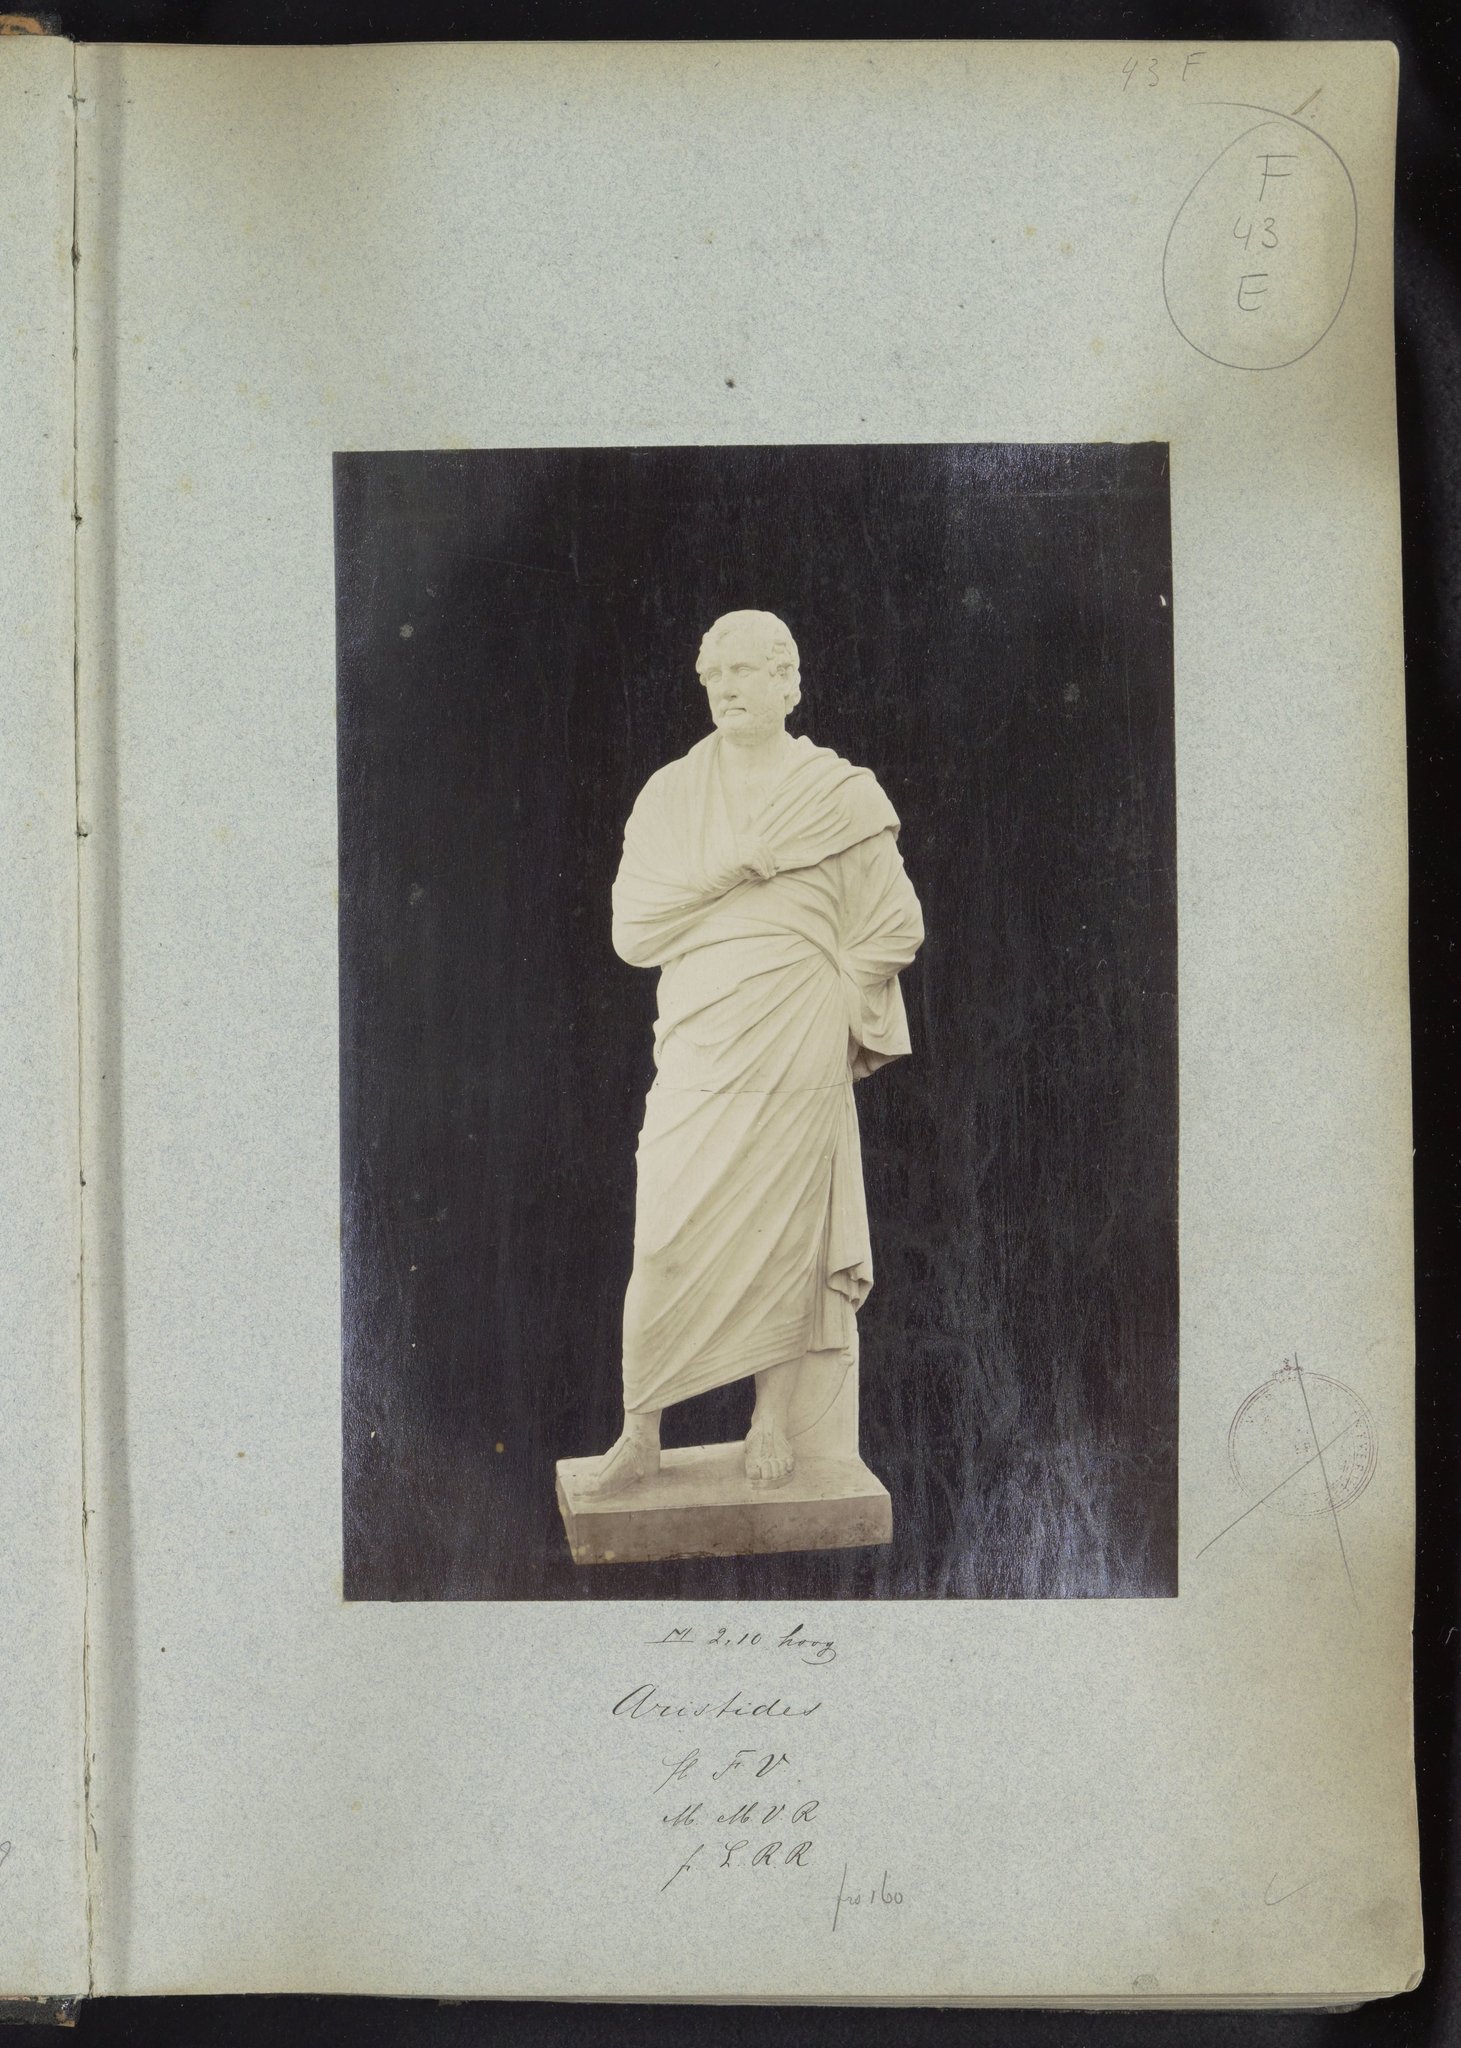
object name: photograph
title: Gipsen afgietsel van een sculptuur van Aristides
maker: Anonymous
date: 1875-1900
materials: paper, photographic support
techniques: albumen print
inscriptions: annotation: ‘M 2.10 hoog’, annotation